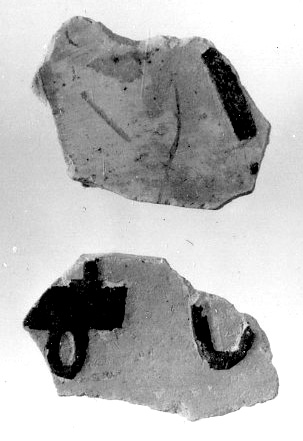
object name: relief fragment, tomb of meketre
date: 1981-1975 BCE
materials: limestone, paint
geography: egypt